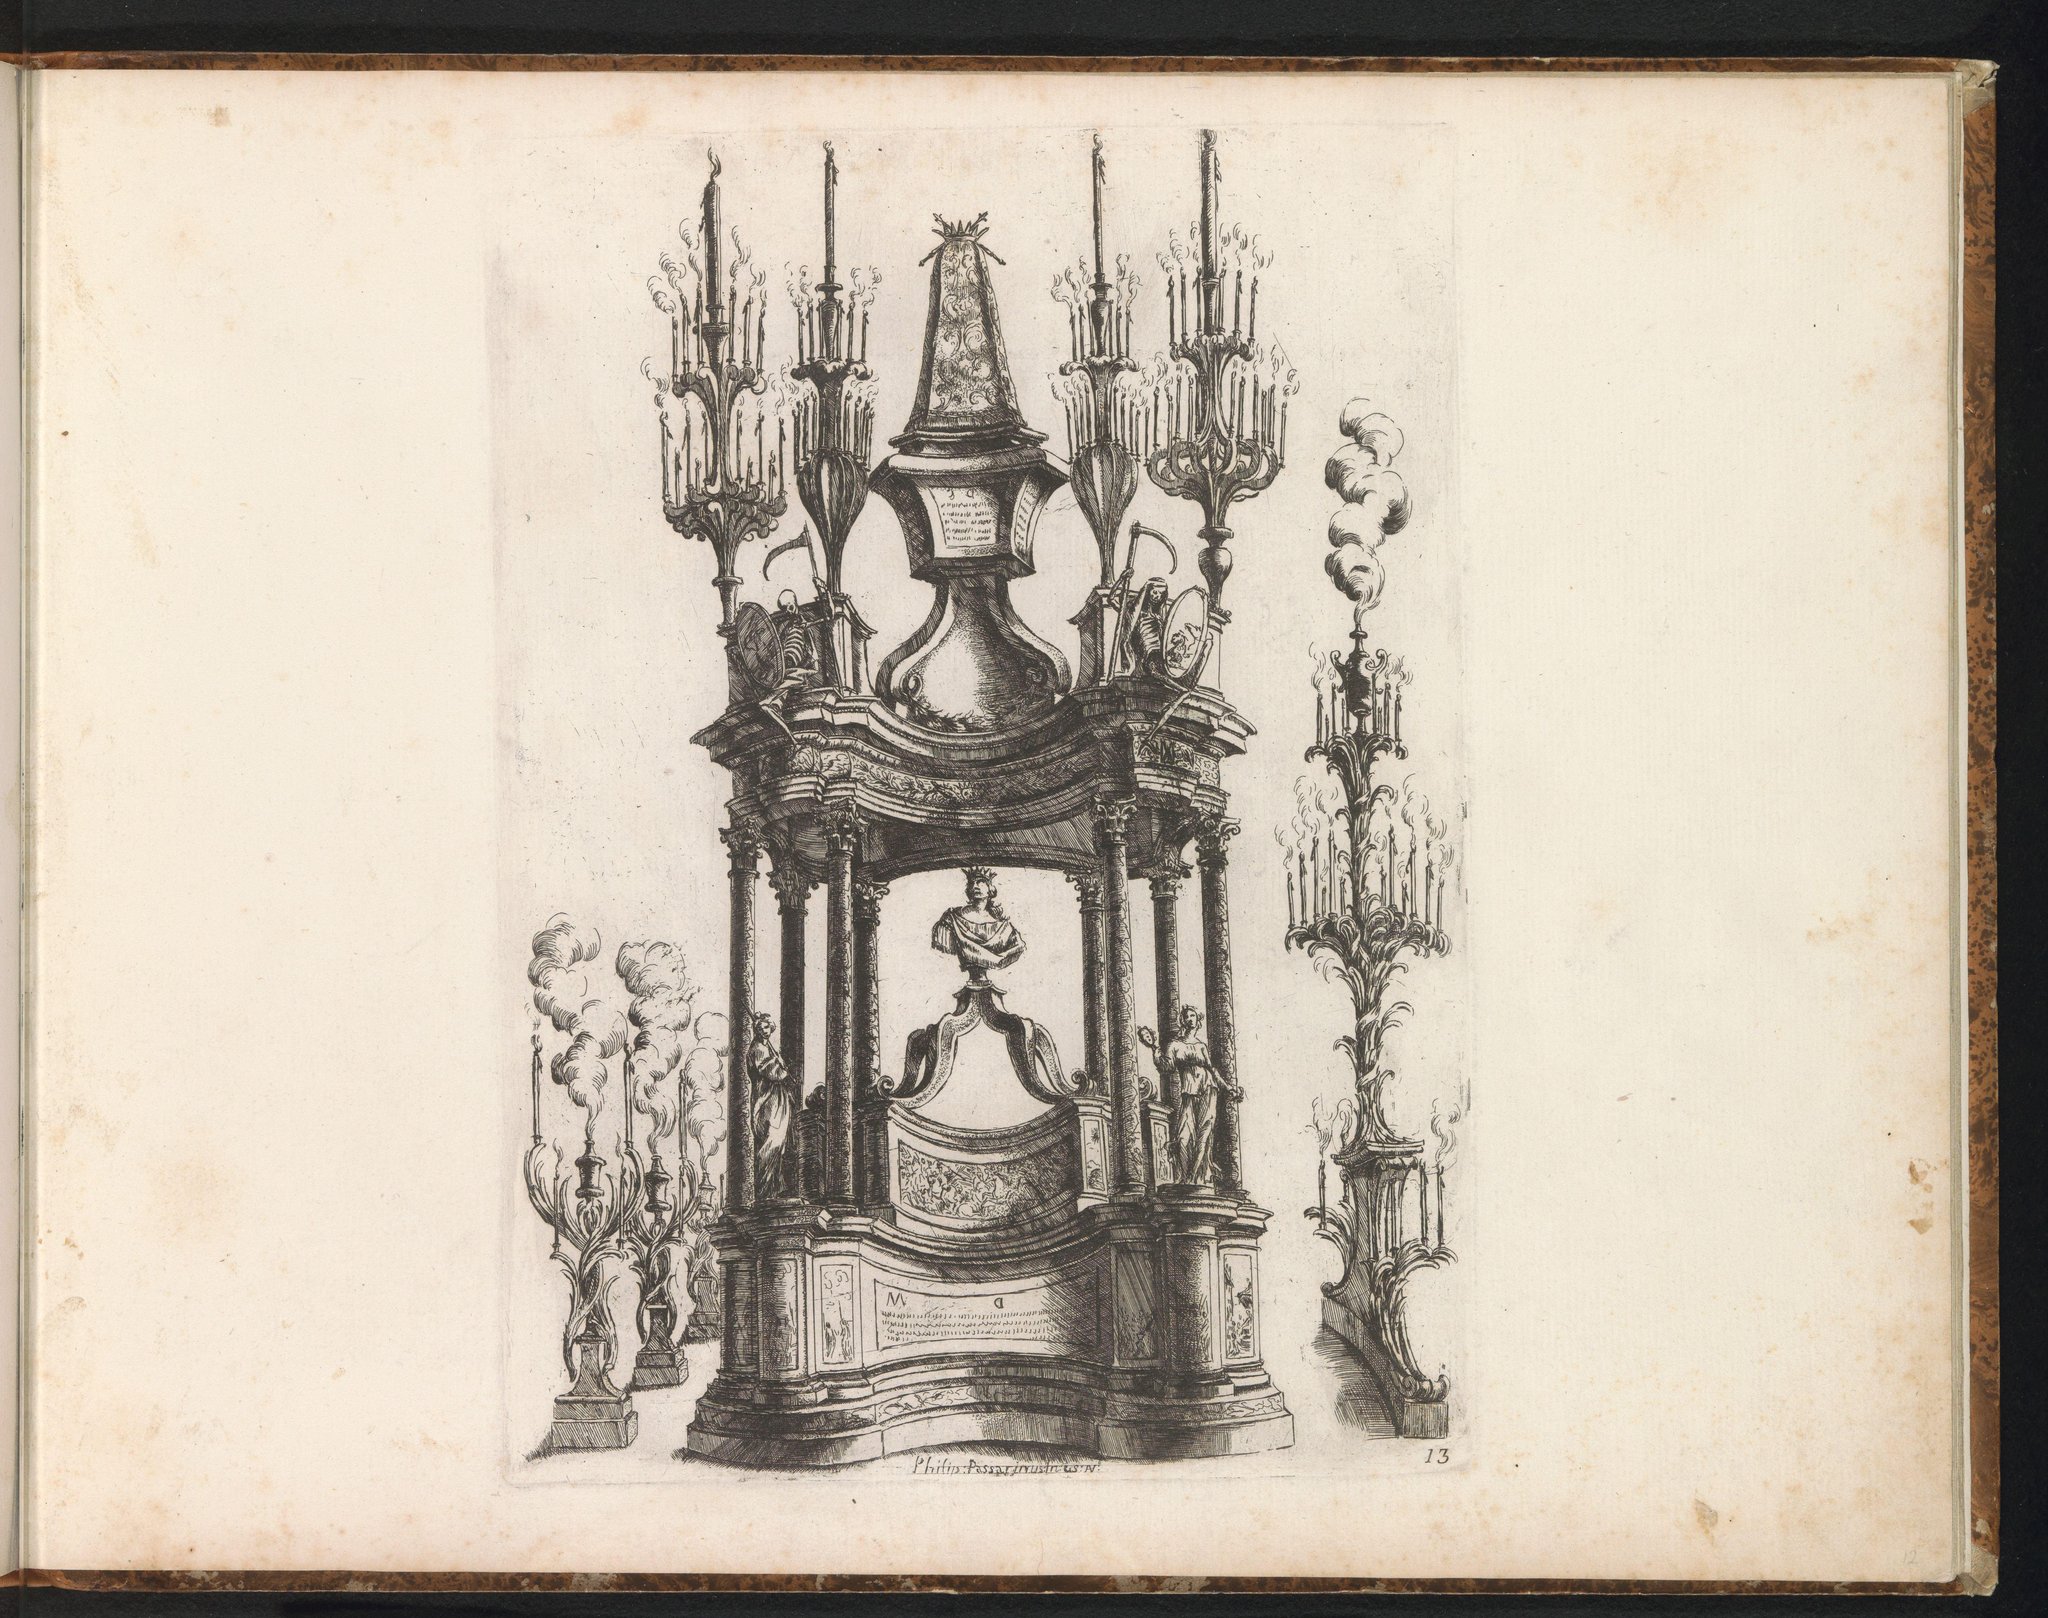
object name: ornament print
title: Nuove invenzioni d'ornamenti d'architettura e d'intagli diversi utili ad argentieri intagliatori ricamentori et altri professori delle buone arti del disegno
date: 1698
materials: paper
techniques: etching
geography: italy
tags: catafalque, 'castrum doloris' (~ public funeral)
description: Ontwerp voor een katafalk. Prent in een album met 22 etsen uit een serie van oorspronkelijk 32 ornamentprenten met uitbundige barokke ontwerpen voor altaren, preekstoelen, orgelkasten en andere kerkelijke kunstnijverheid, gevolgd door ontwerpen voor hemelbedden, kinderledikanten en ander huiselijke meubilair.